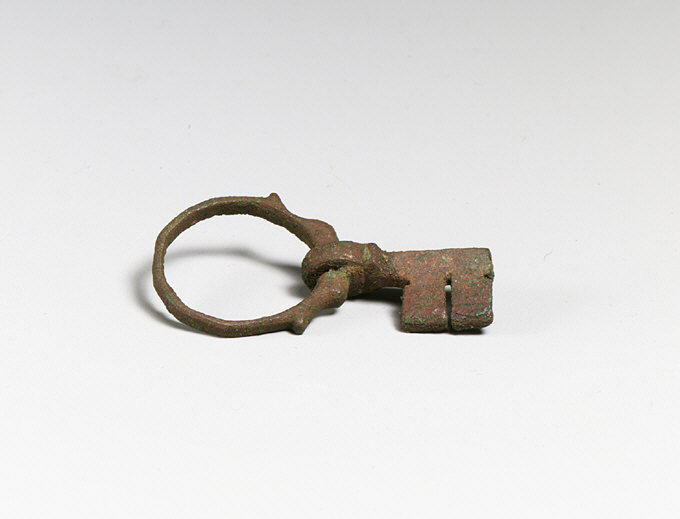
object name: key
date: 7000 BCE-330 CE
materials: bronze